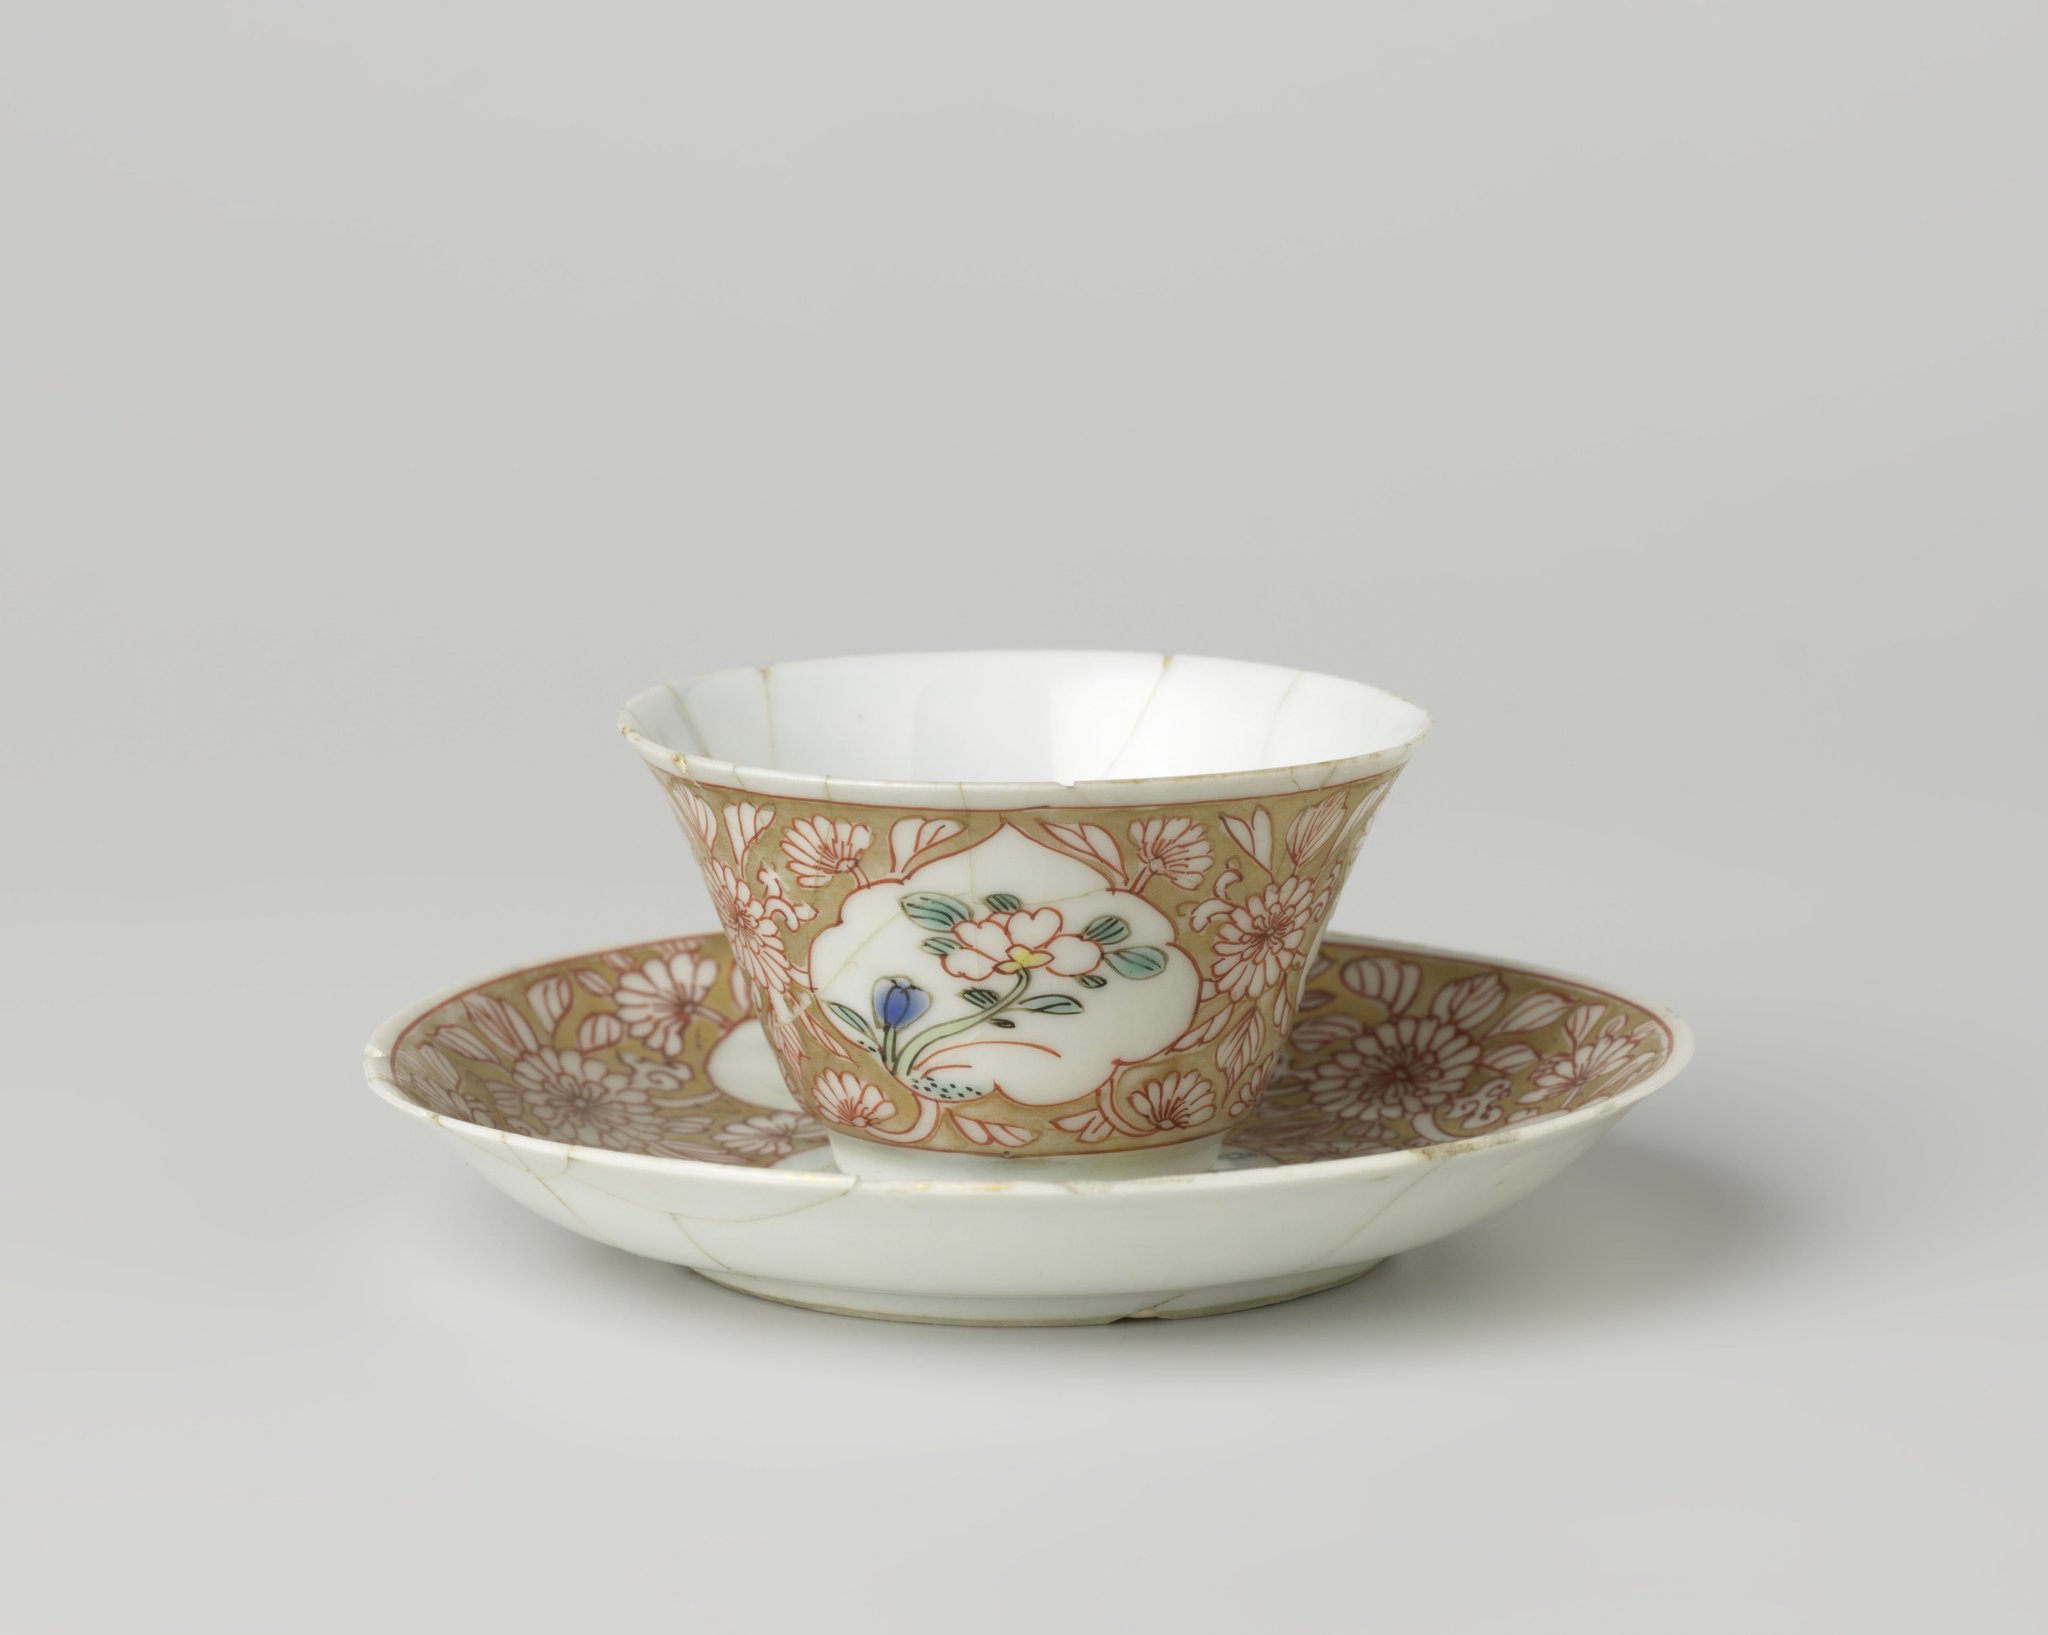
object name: kop en schotel, kop en schotel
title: Cup and saucer with a woman with flower basket and flowering plants in panels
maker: Anonymous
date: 1725-1749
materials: glaze, gold, paint, porcelain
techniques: firing, gilding, turning, vitrification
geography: china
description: Kop en schotel van porselein met spreidende wand, beschilderd op het glazuur in blauw, rood, roze, groen, zwart en goud. Op het plat van de schotel een medaillon met een vrouw in een landschap met een bloemenmand; om het medaillon uitgespaarde bloemranken en drie cartouches met bloeiende planten (o.a. lotus) in een gouden grond. Schotel en kop zijn gebroken geweest. Famille rose.